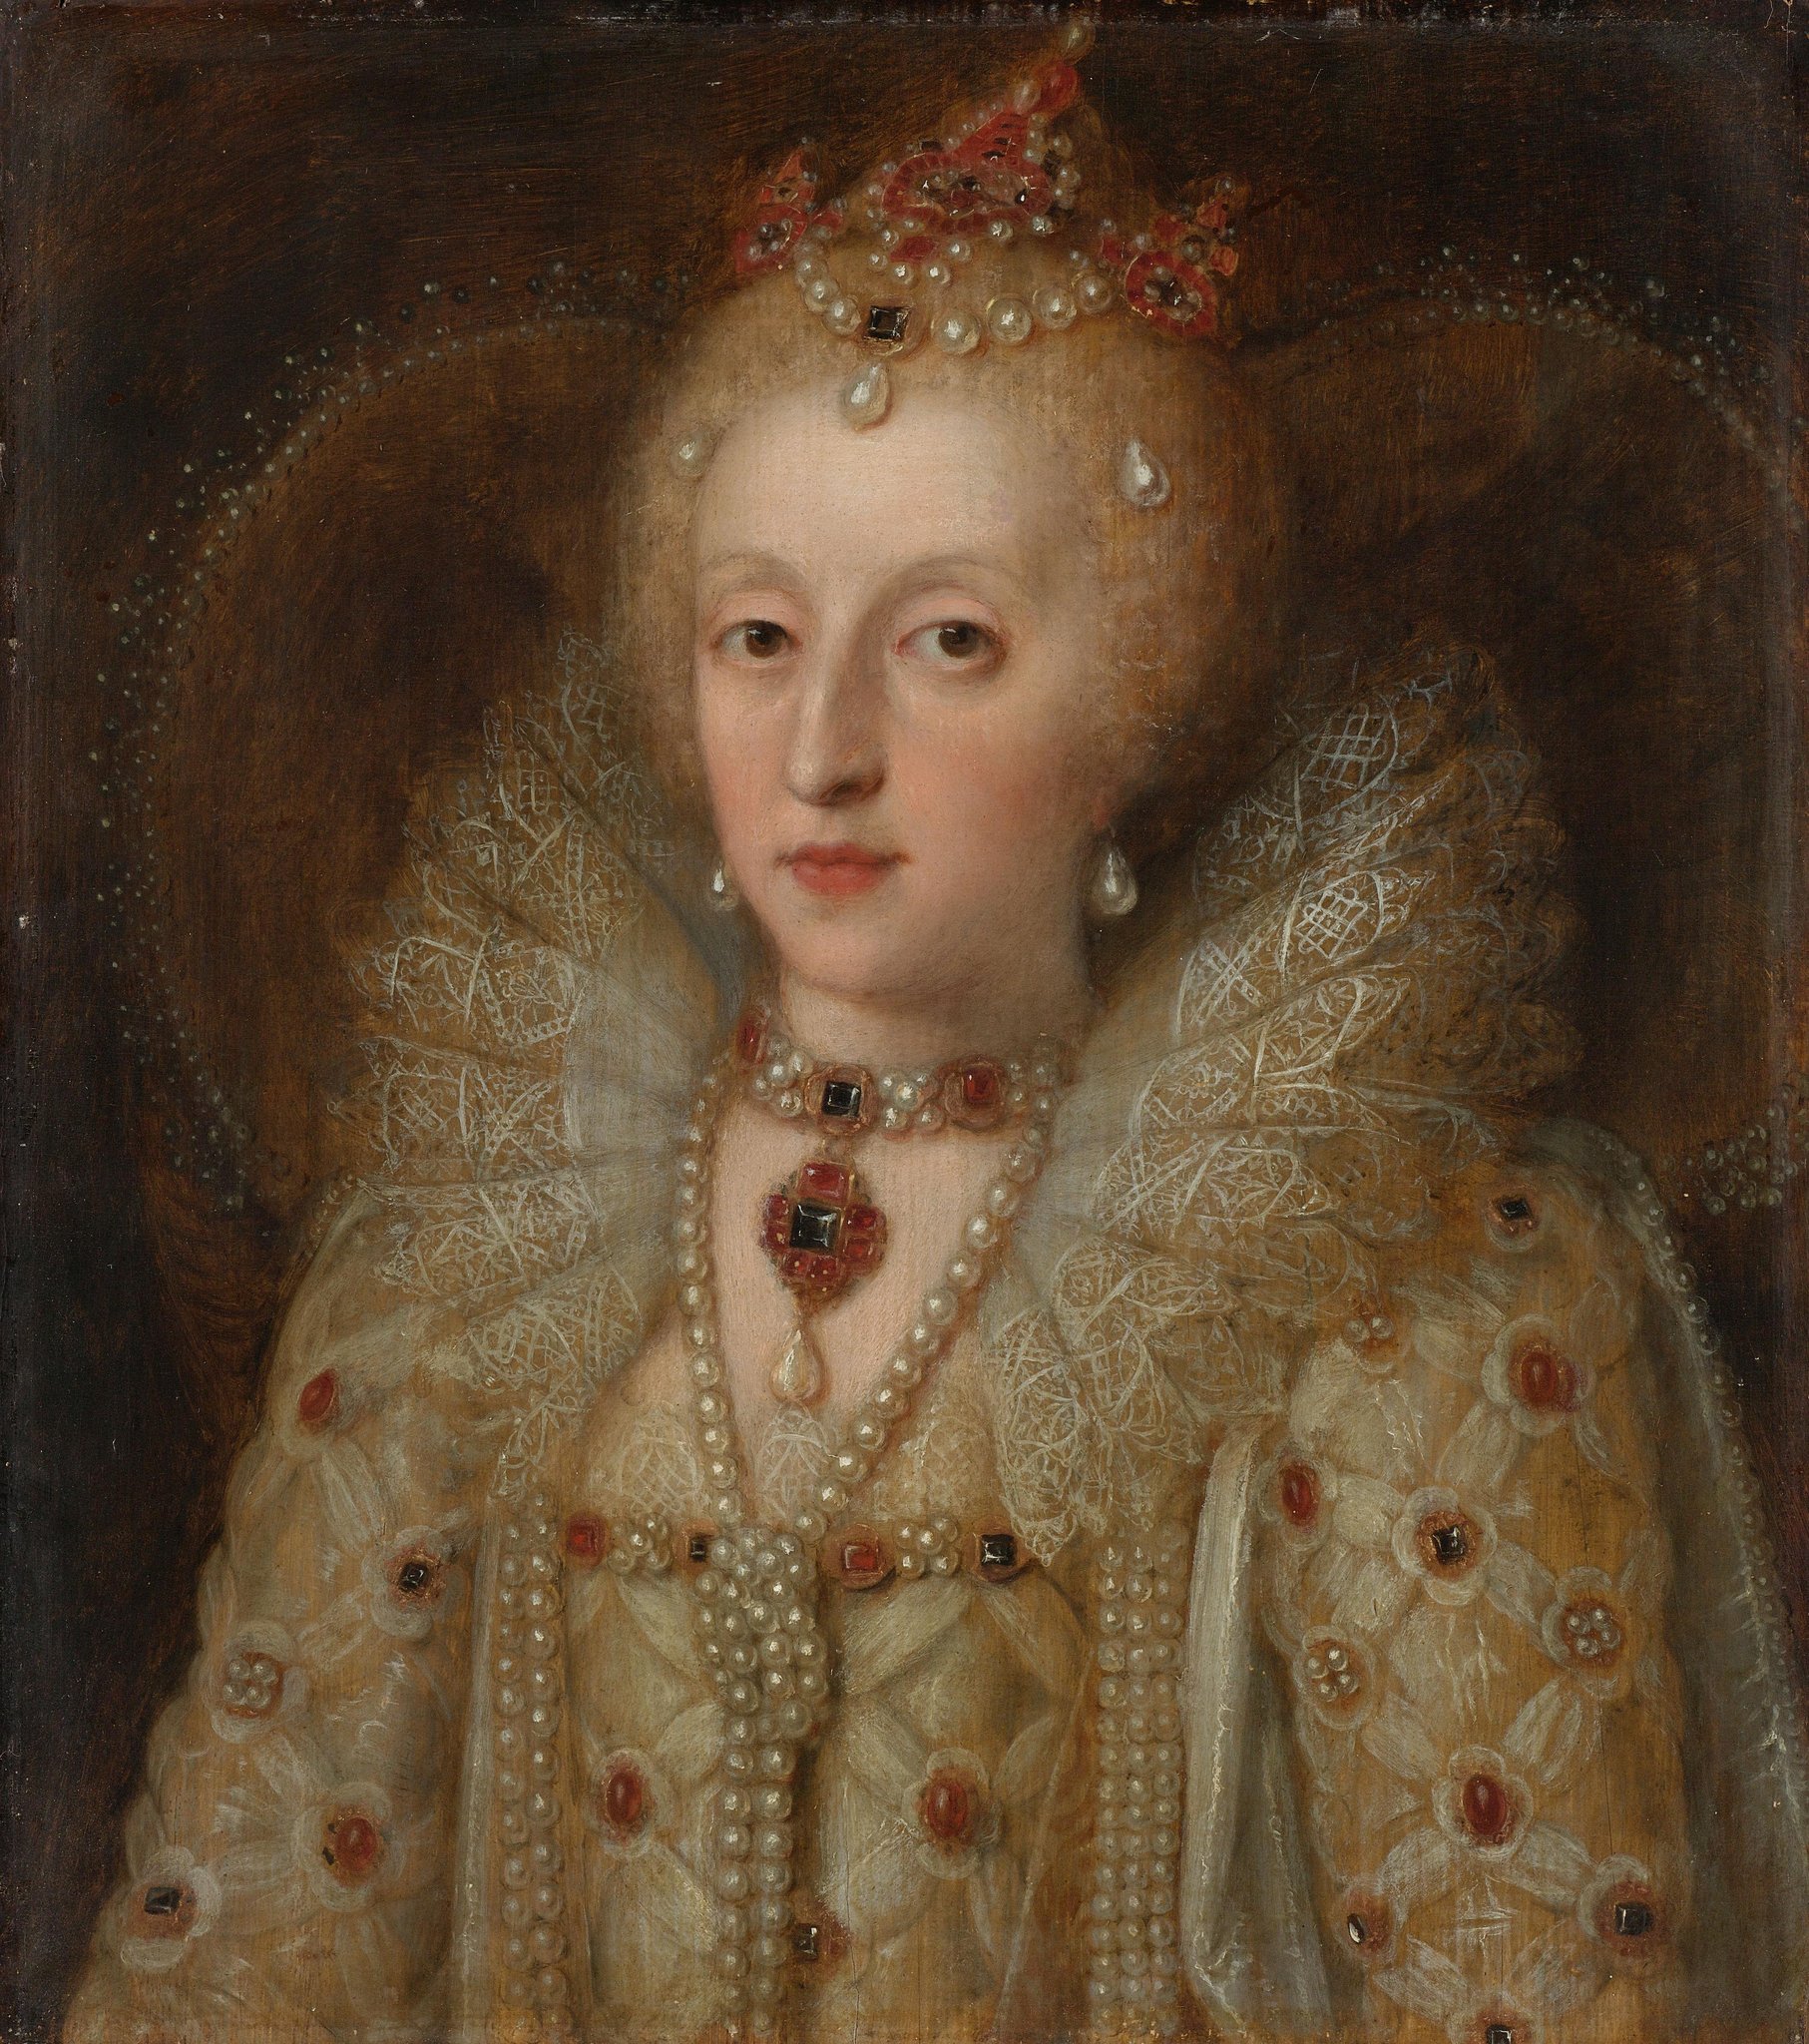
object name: painting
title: Portrait of Elizabeth I, Queen of England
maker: Anonymous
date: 1550-1599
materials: oil, panel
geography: england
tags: historical persons - bb - woman, netherlands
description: Elisabeth I, 1533-1603, koningin van Engeland. Door een onbekende Engelse schilder. Deze grondlegster van de Engelse wereldmacht speelde een ondoorzichtig spel in haar politiek ten opzichte van de opstandige gewesten. Zij weigerde in 1585 de haar aangeboden souvereiniteit over de Republiek, maar na de val van Antwerpen zond zij geld en 5.000 man. Zij zond Leicester als bevelhebber, die door een eigen politiek zowel met zijn vorstin als met de Nederlanders in moeilijkheden kwam.